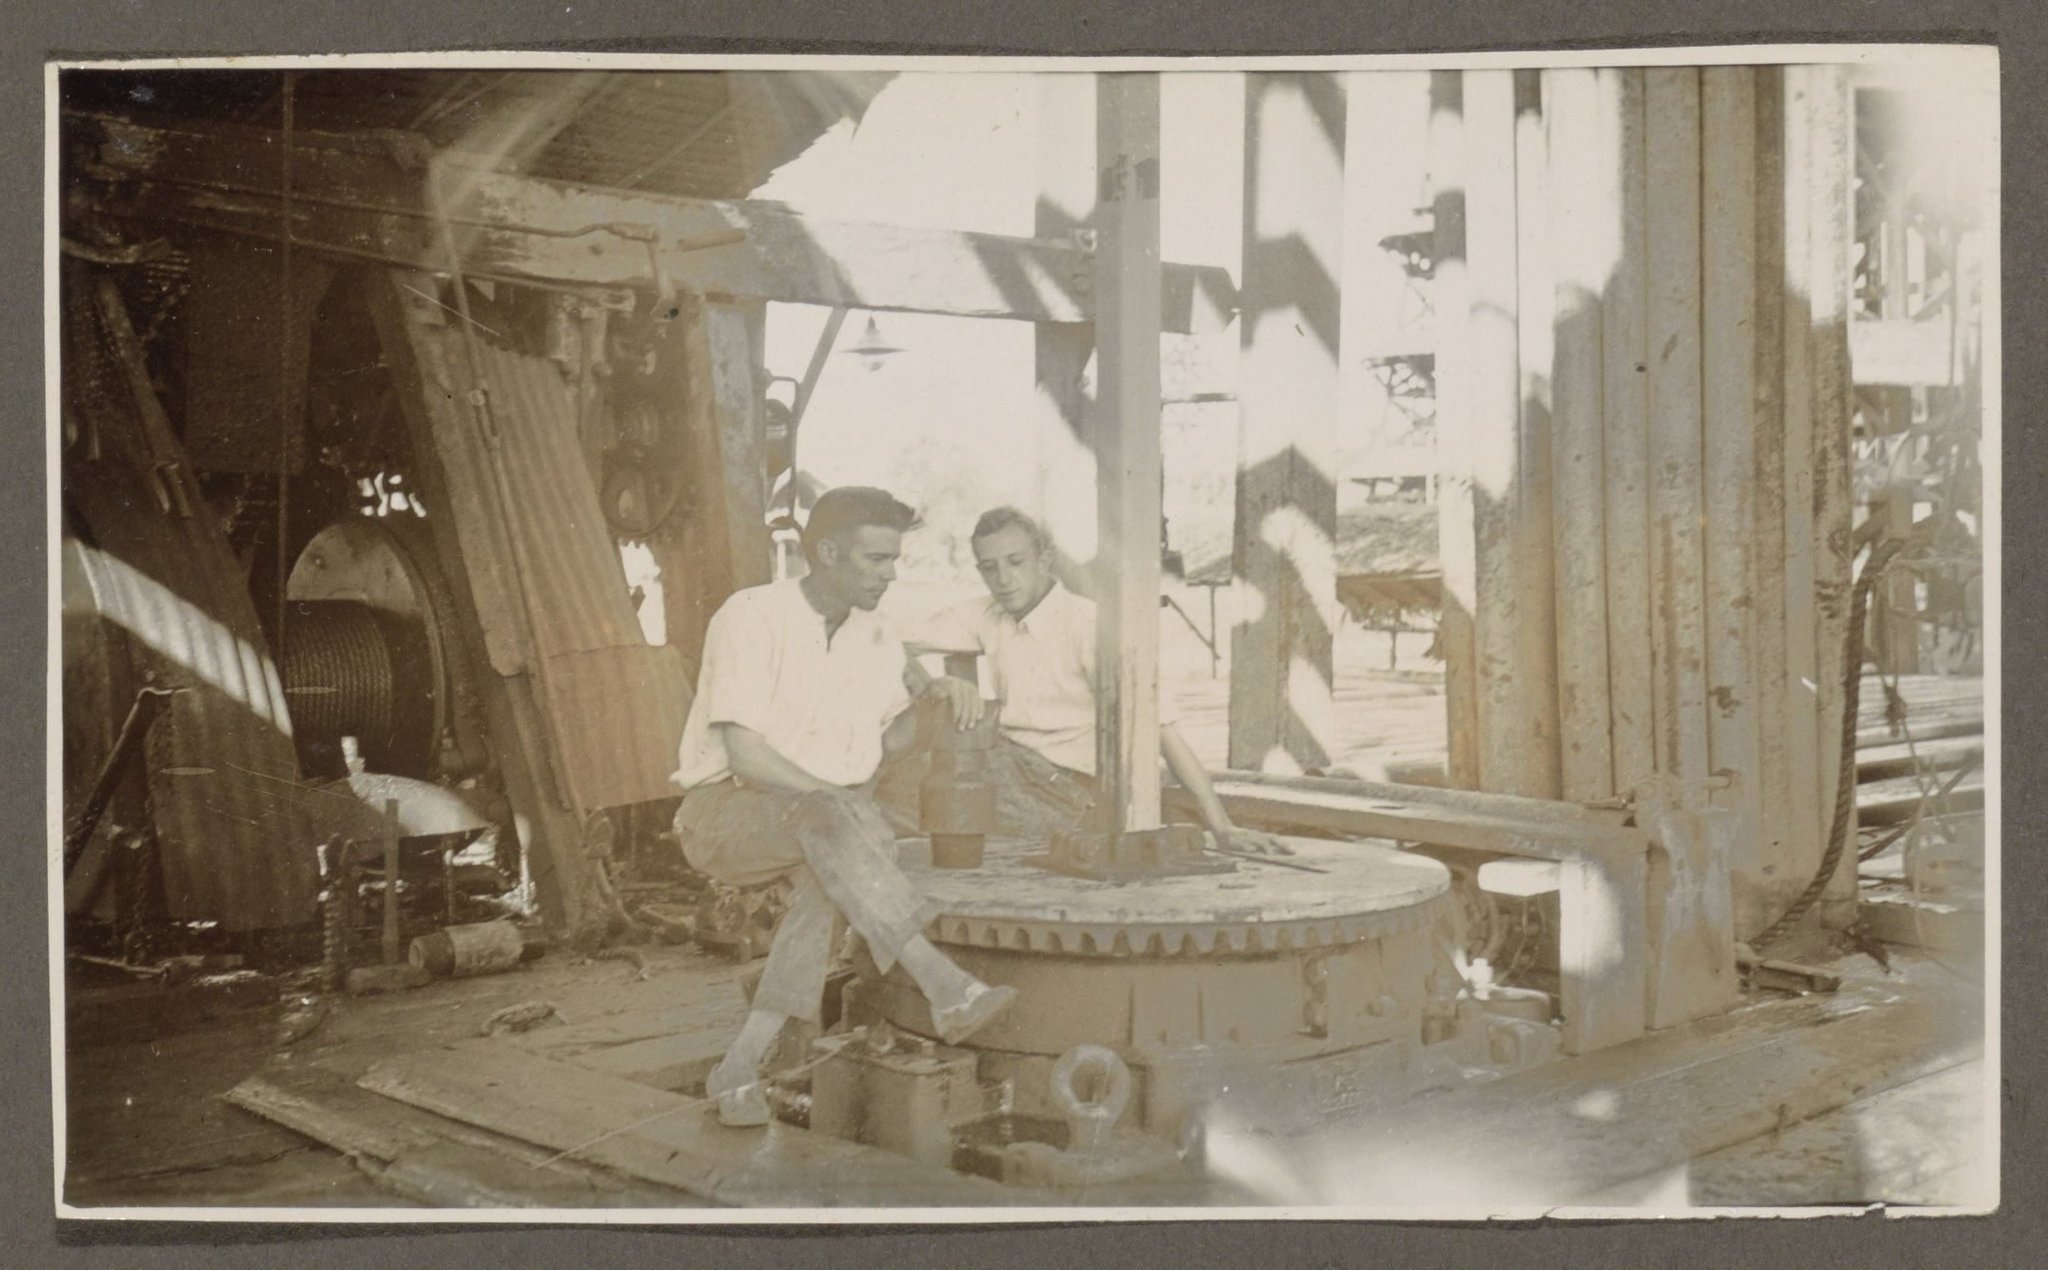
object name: photograph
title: Twee mannen zittend in een boortoren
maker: Anonymous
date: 1920-1930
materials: photographic support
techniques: gelatin silver print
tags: refinery ~ oil, derrick ~ oil, dutch east indies, the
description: Onderdeel van familiealbum Nederlands-Indië.